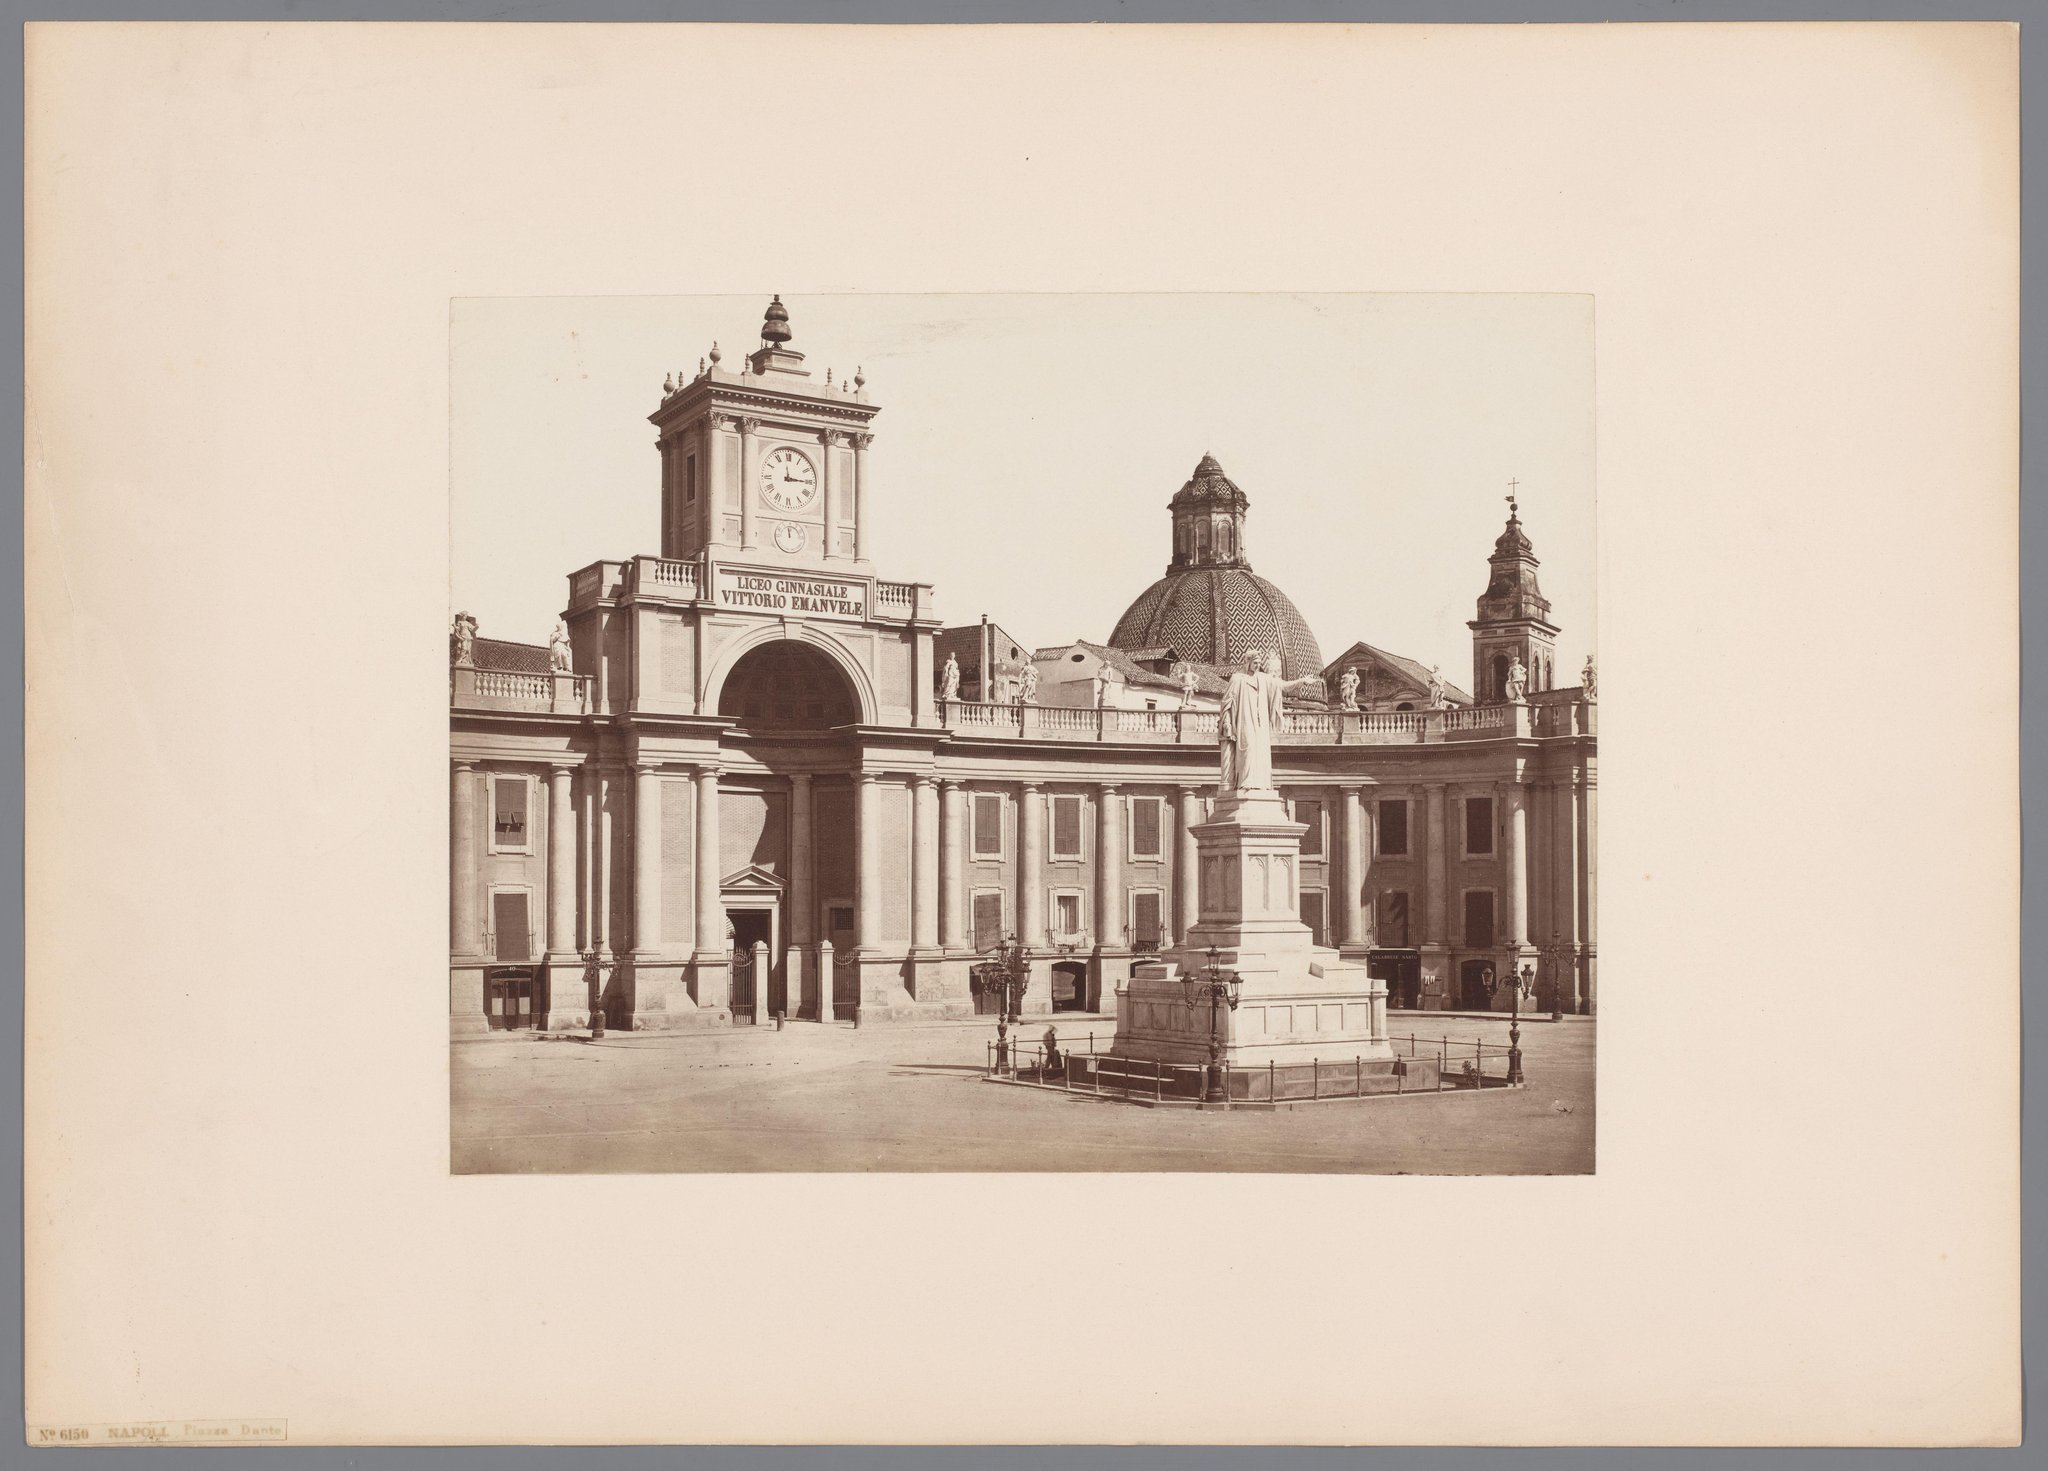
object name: photograph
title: Napoli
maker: giorgio sommer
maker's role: fotograaf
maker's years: 1834-1914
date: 1871-1914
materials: cardboard, paper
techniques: albumen print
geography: naples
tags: dante alighieri, square, place, circus, etc., piece of sculpture, reproduction of a piece of sculpture, monument, statue, elementary school; class, form (+ building ~ education, tuition)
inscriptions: number: ‘No. 6150’